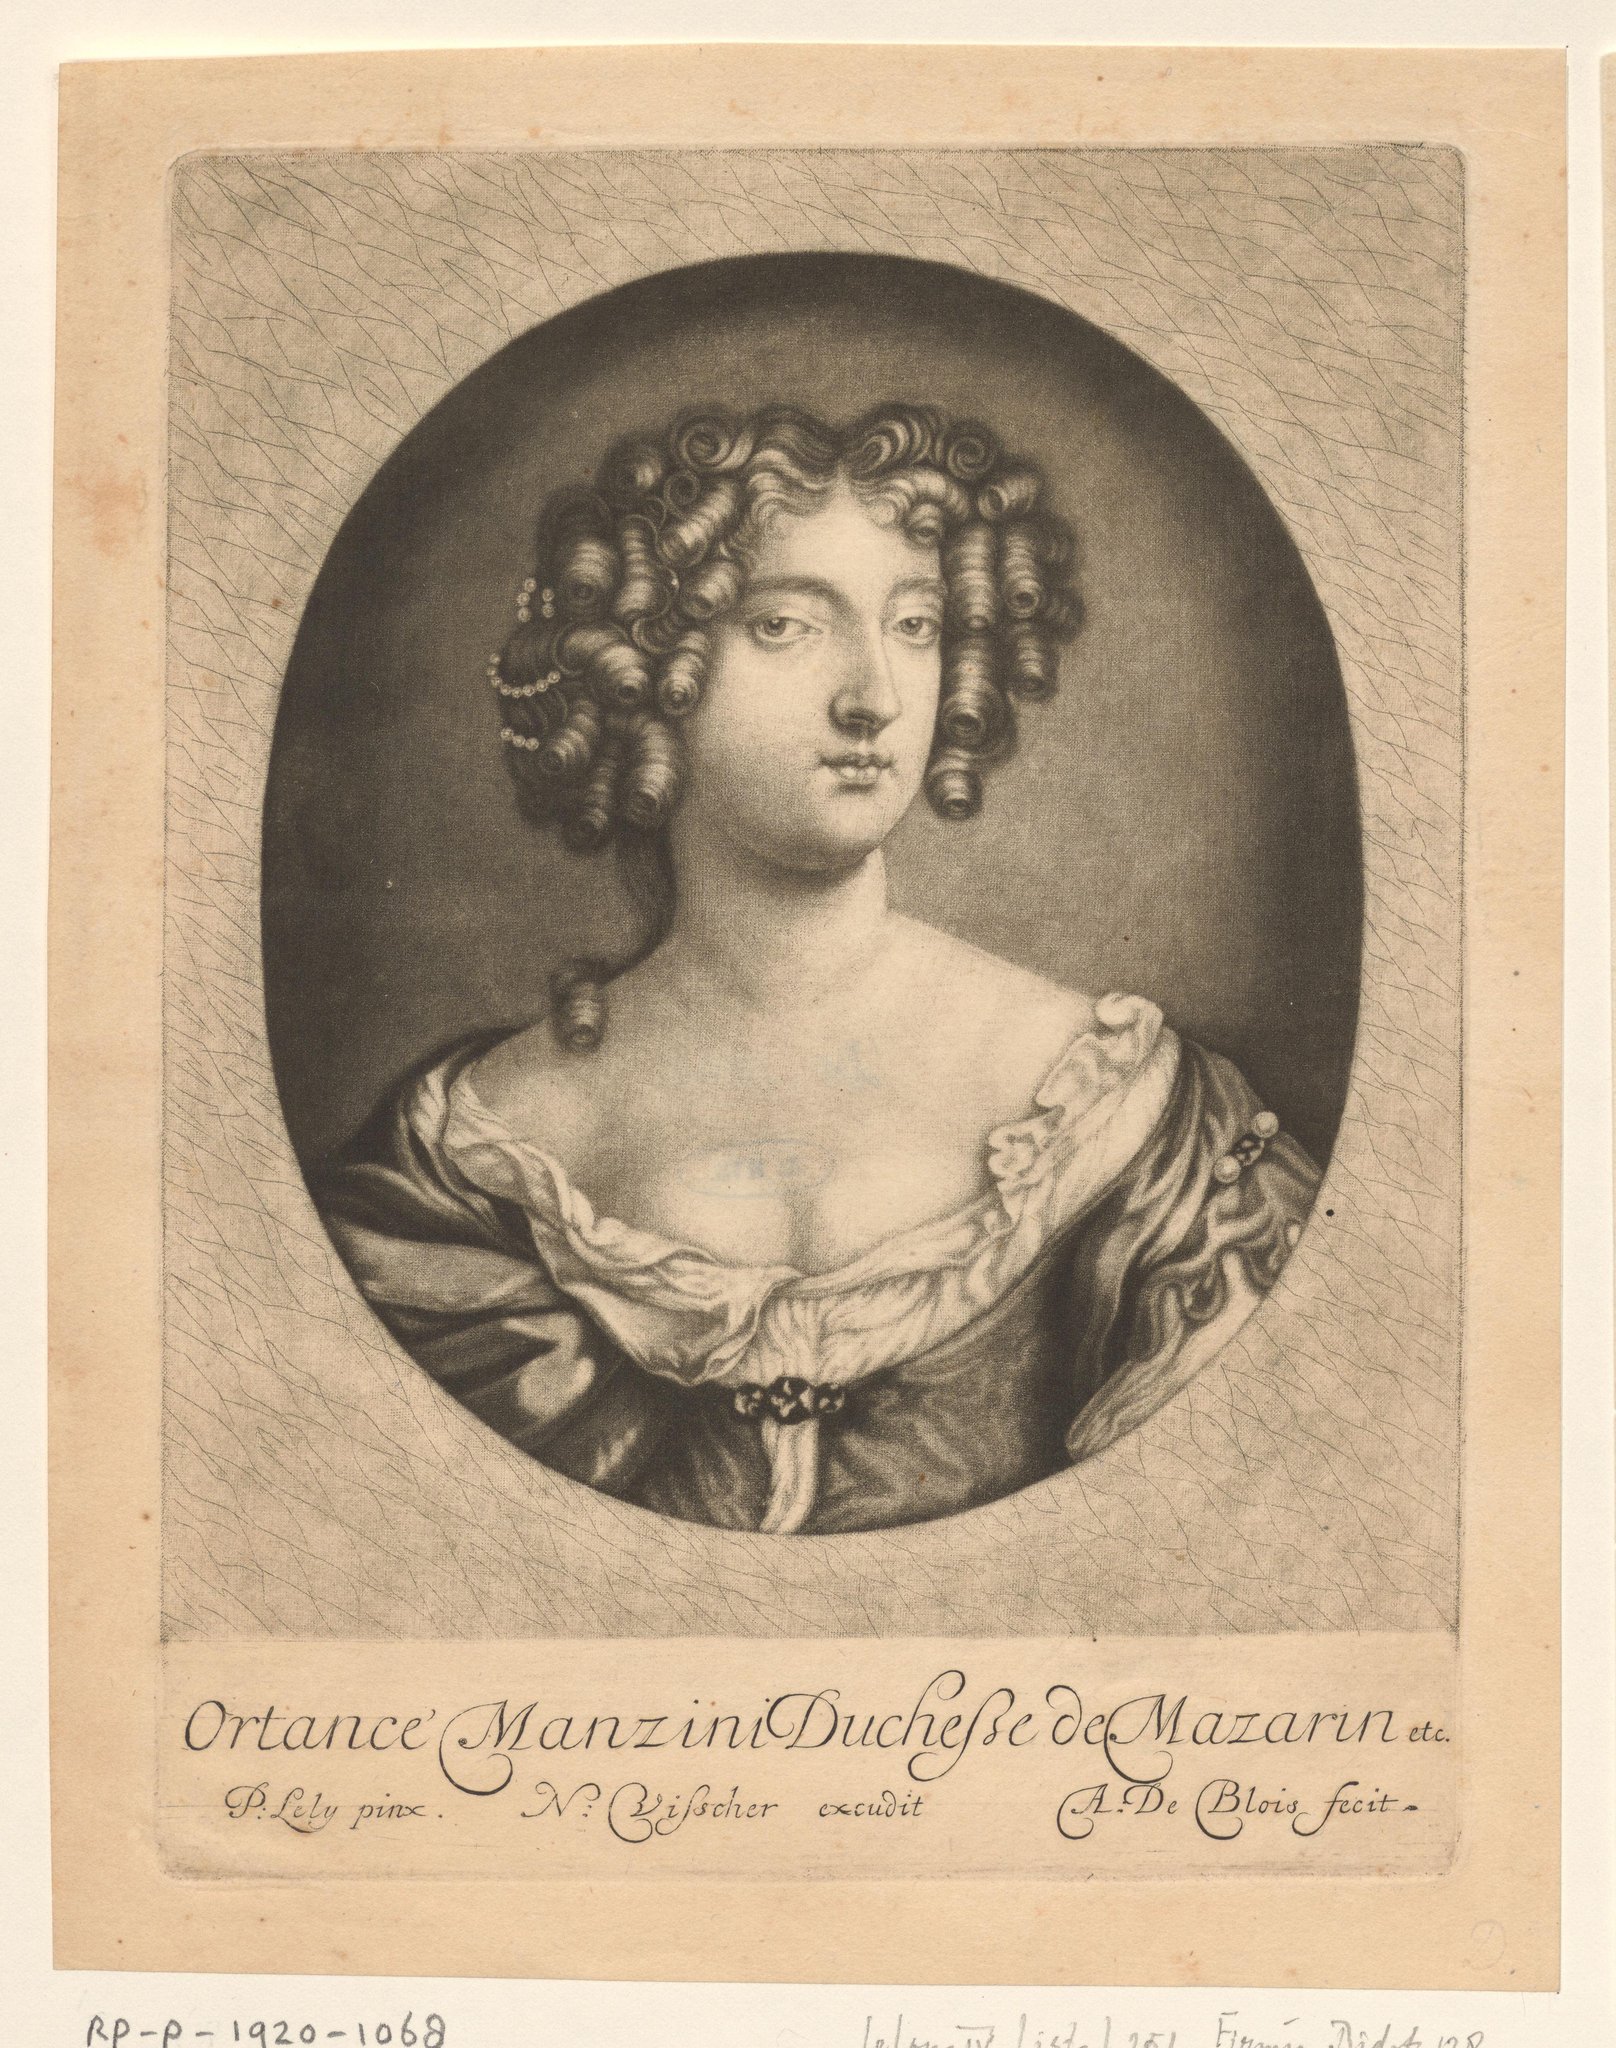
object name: print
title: Portret van Hortense Mancini, hertogin van Mazarin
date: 1679-1702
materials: paper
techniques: engraving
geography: amsterdam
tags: rome, historical persons - bb - woman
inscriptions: collector's mark: Lugt 2228, monogram: ‘NN’